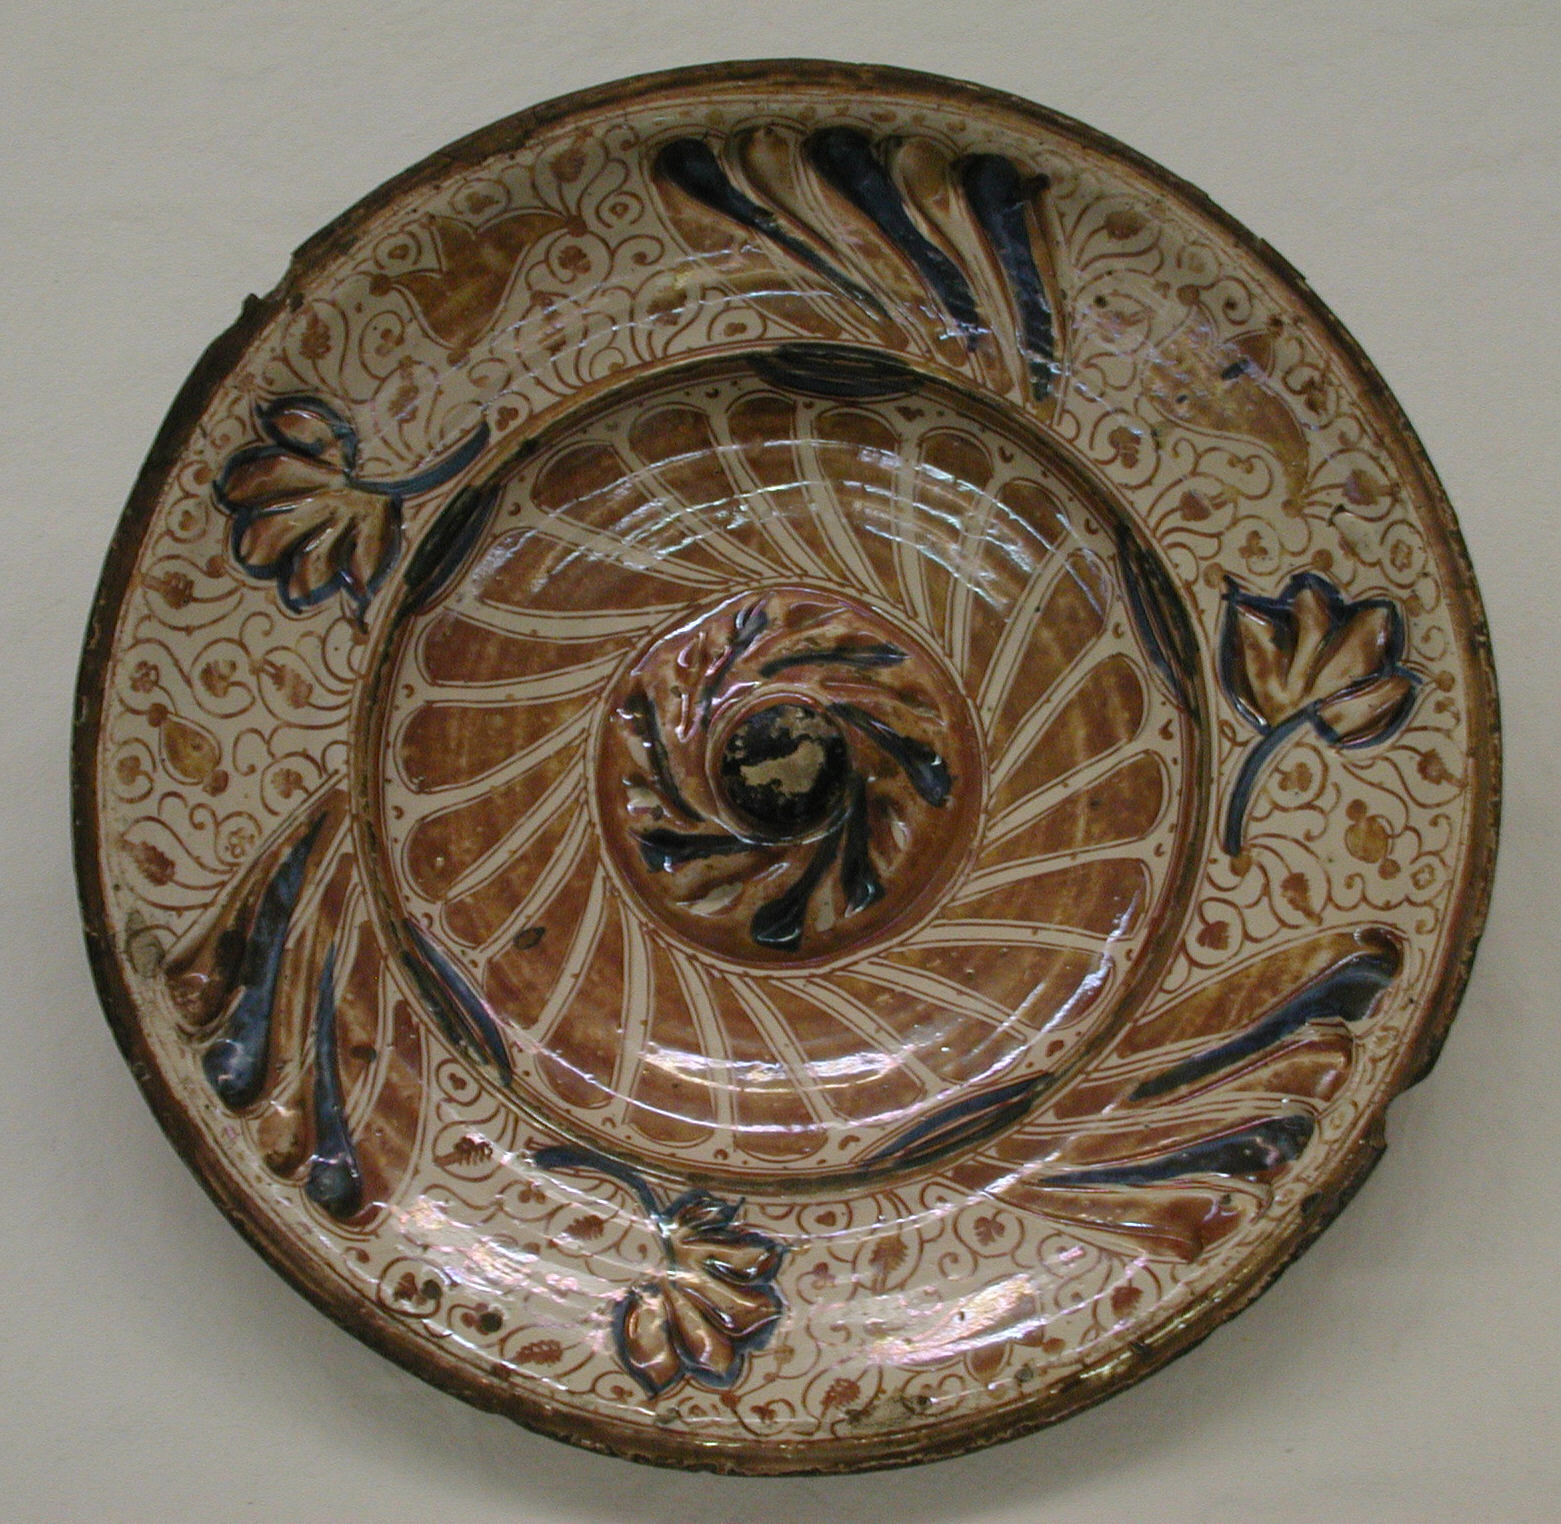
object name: dish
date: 1601-1700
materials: earthenware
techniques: luster painting, glazing